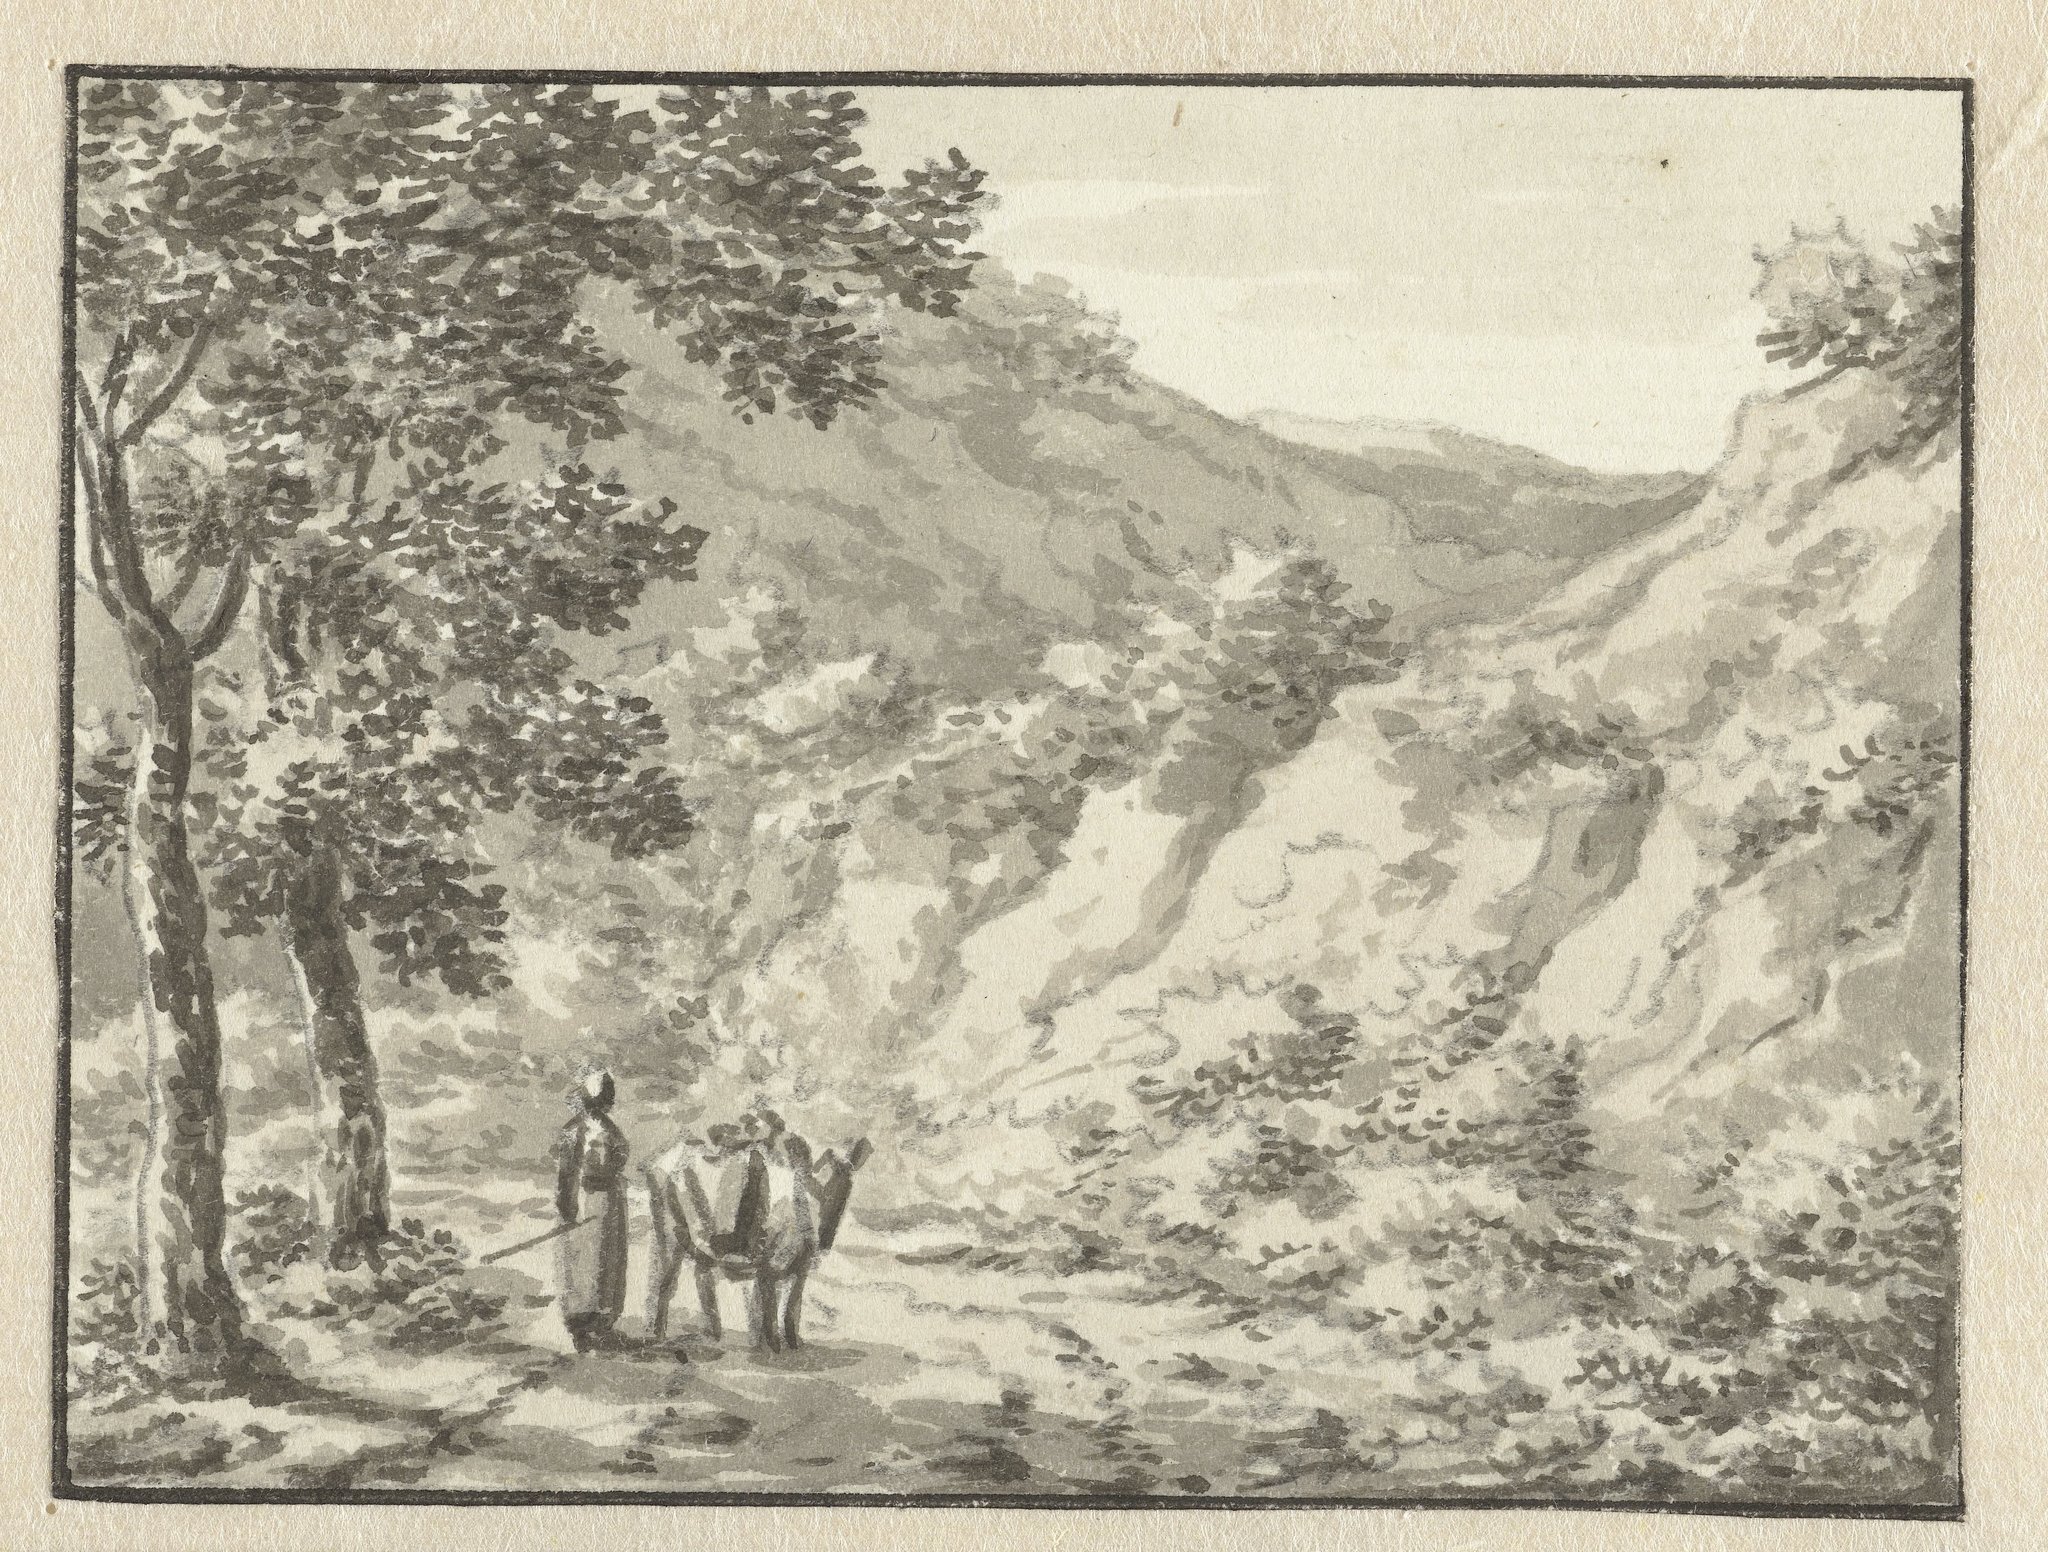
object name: drawing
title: Landschap met een man met lastdier op een bergweg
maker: anthony andriessen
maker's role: draughtsman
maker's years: 1746-1813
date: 1756-1813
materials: paper, pencil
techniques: brush